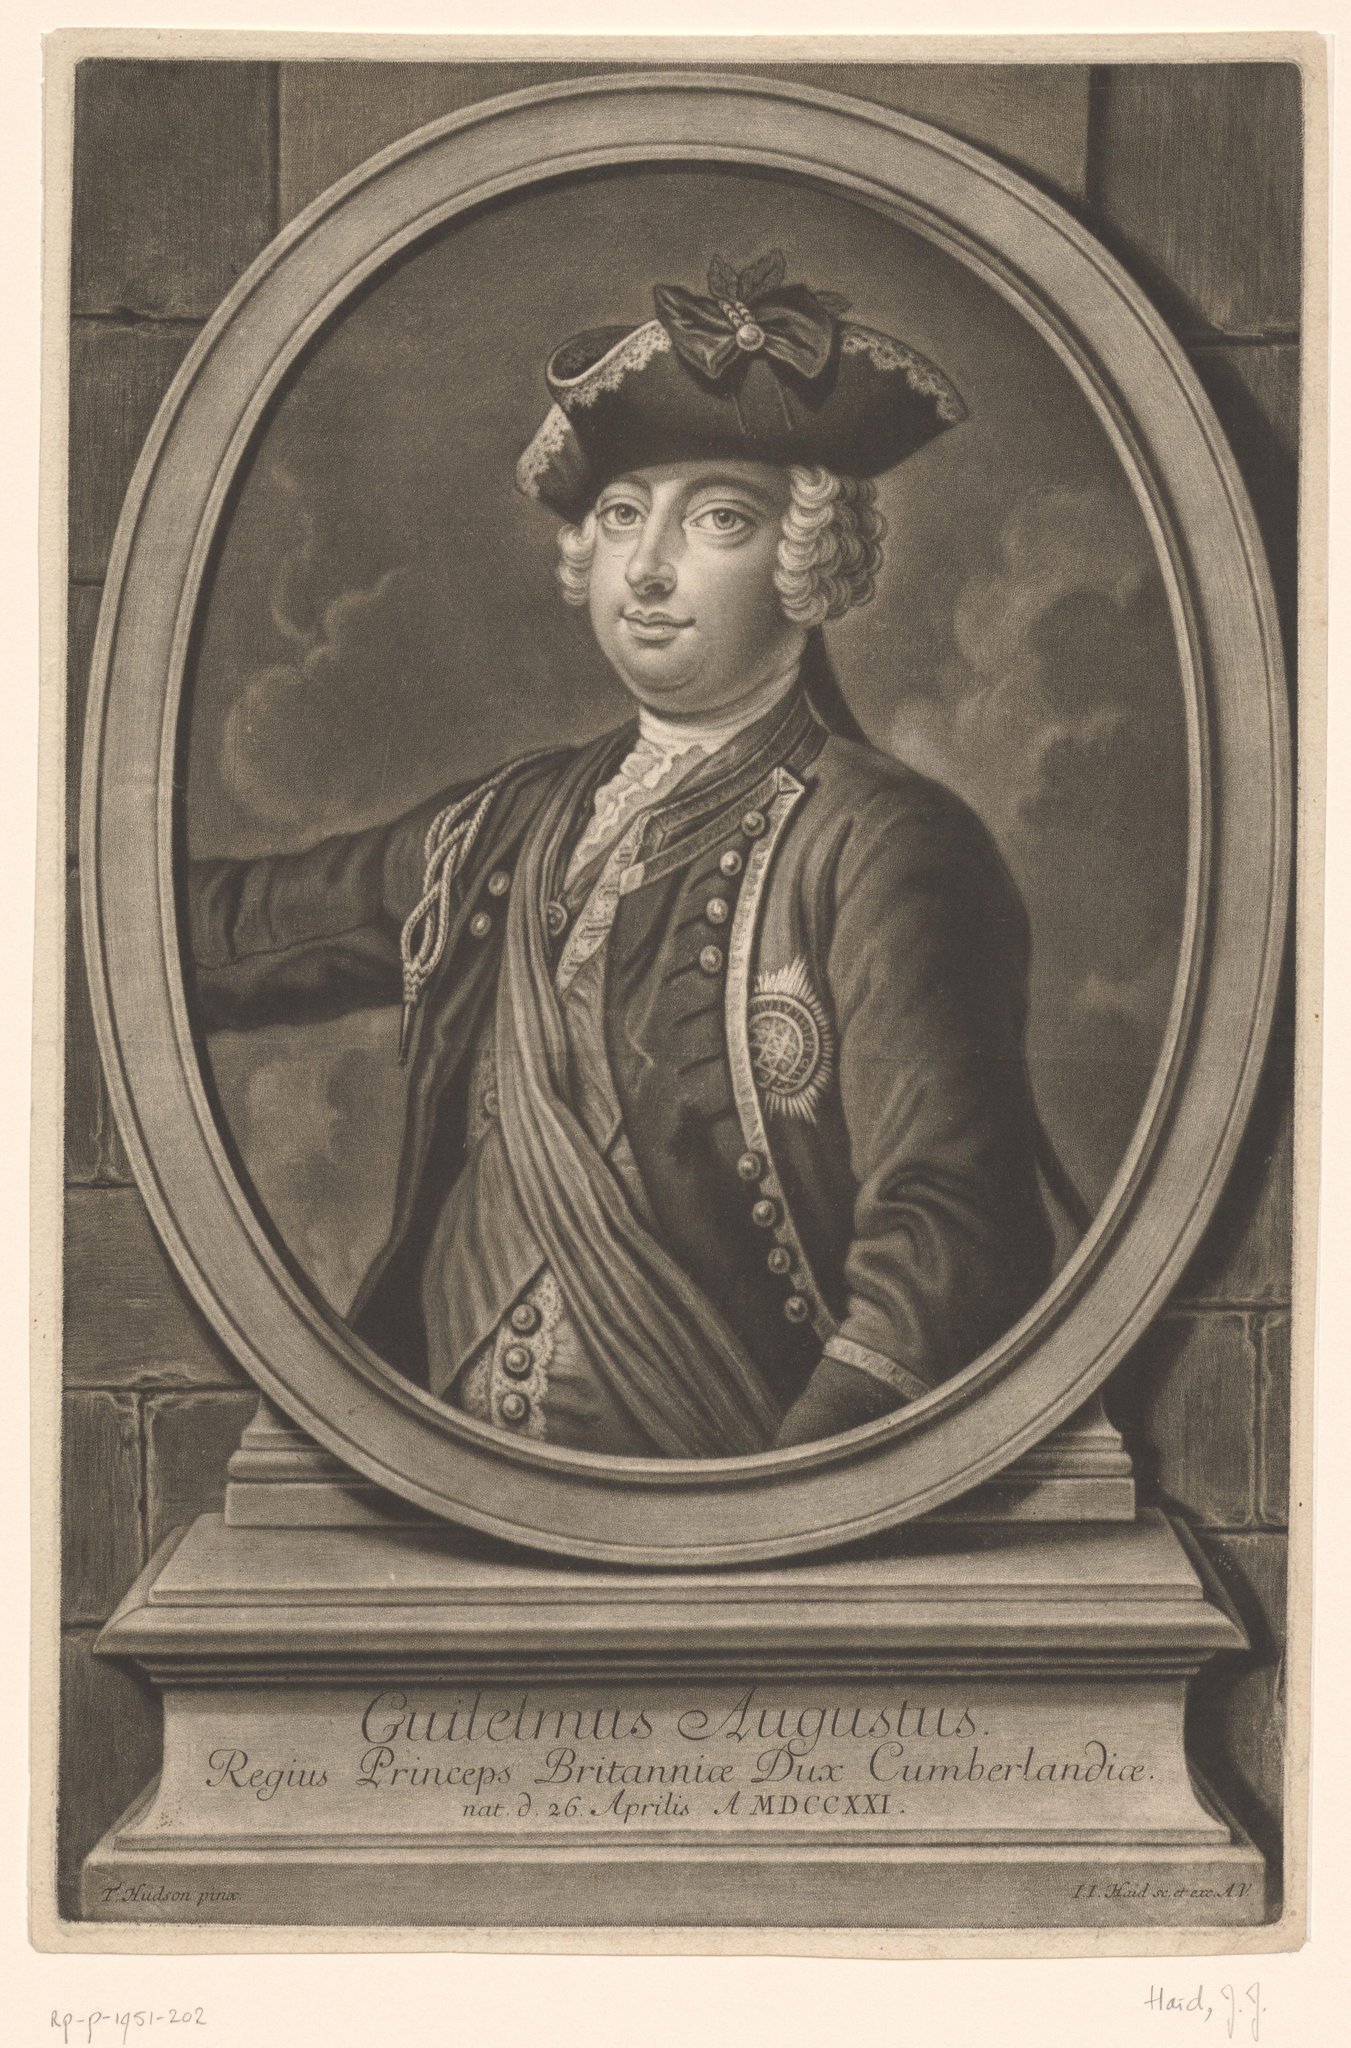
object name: print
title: Portret van hertog Willem van Cumberland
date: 1737-1767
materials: paper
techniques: engraving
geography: augsburg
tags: historical persons